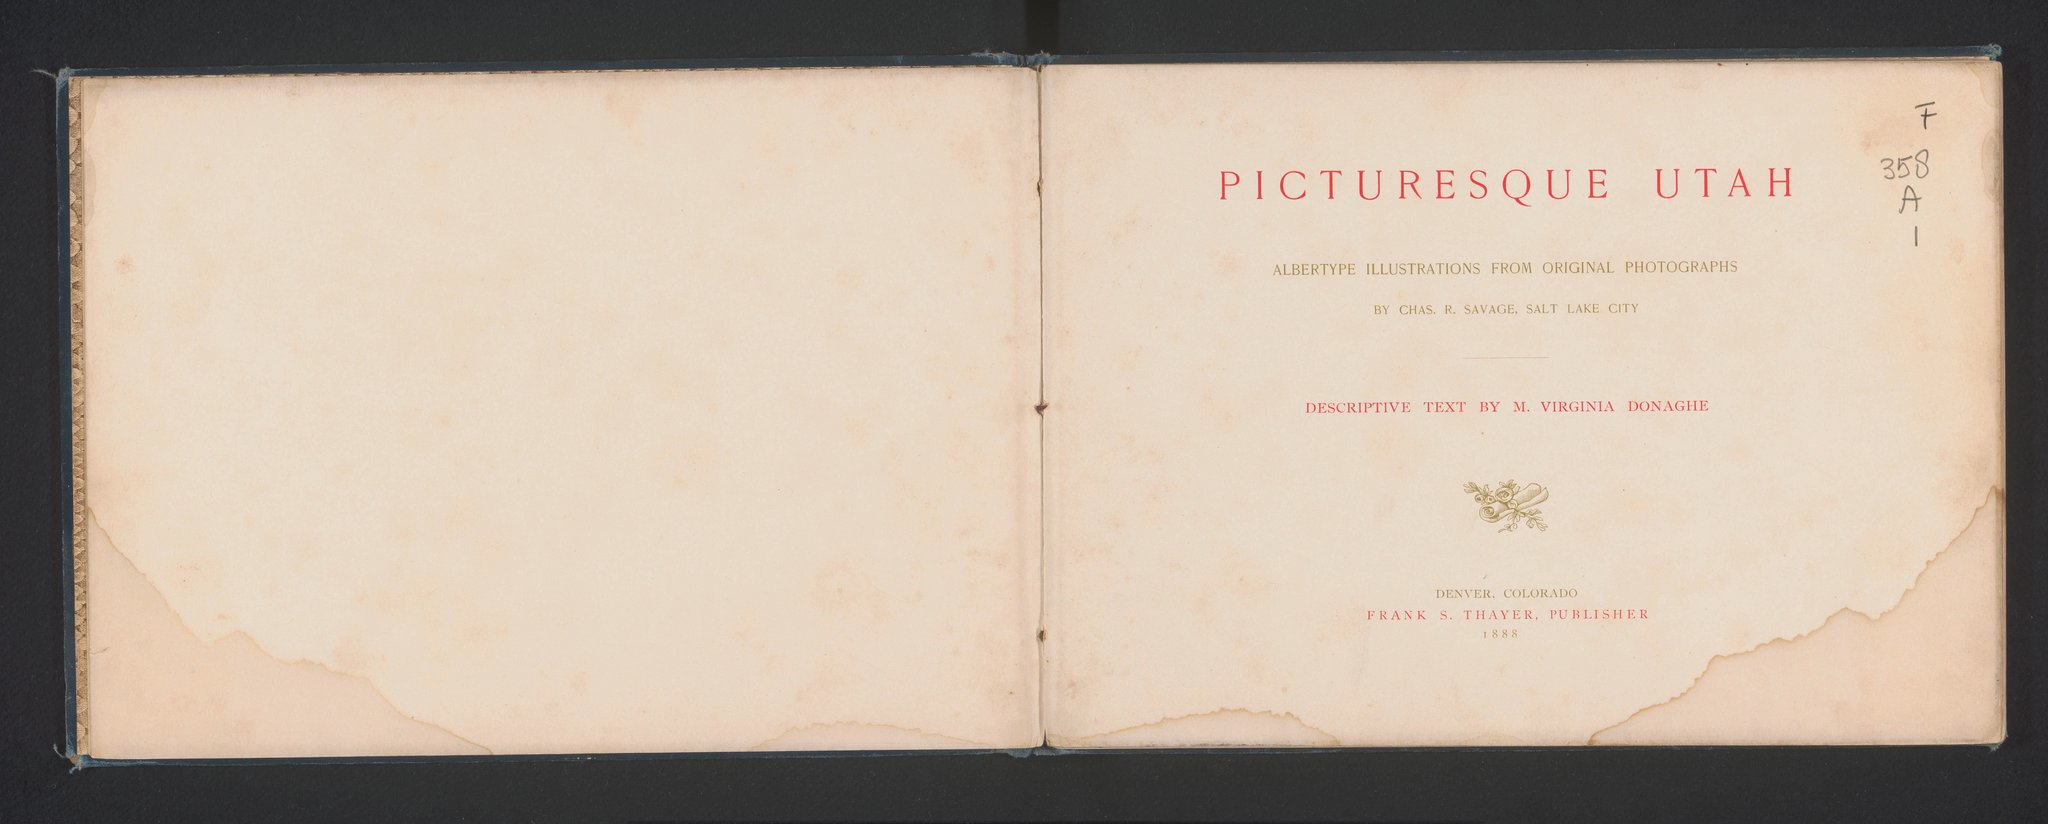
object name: book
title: Picturesque Utah / descriptive text by M. Virginia Donaghe; albertype ill. from original photographs by Chas. R. Savage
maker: virginia donaghe mcclurg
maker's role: schrijver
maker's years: 1857-1931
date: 1888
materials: cardboard, linen, paper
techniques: albumen print, photograph, printing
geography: denver